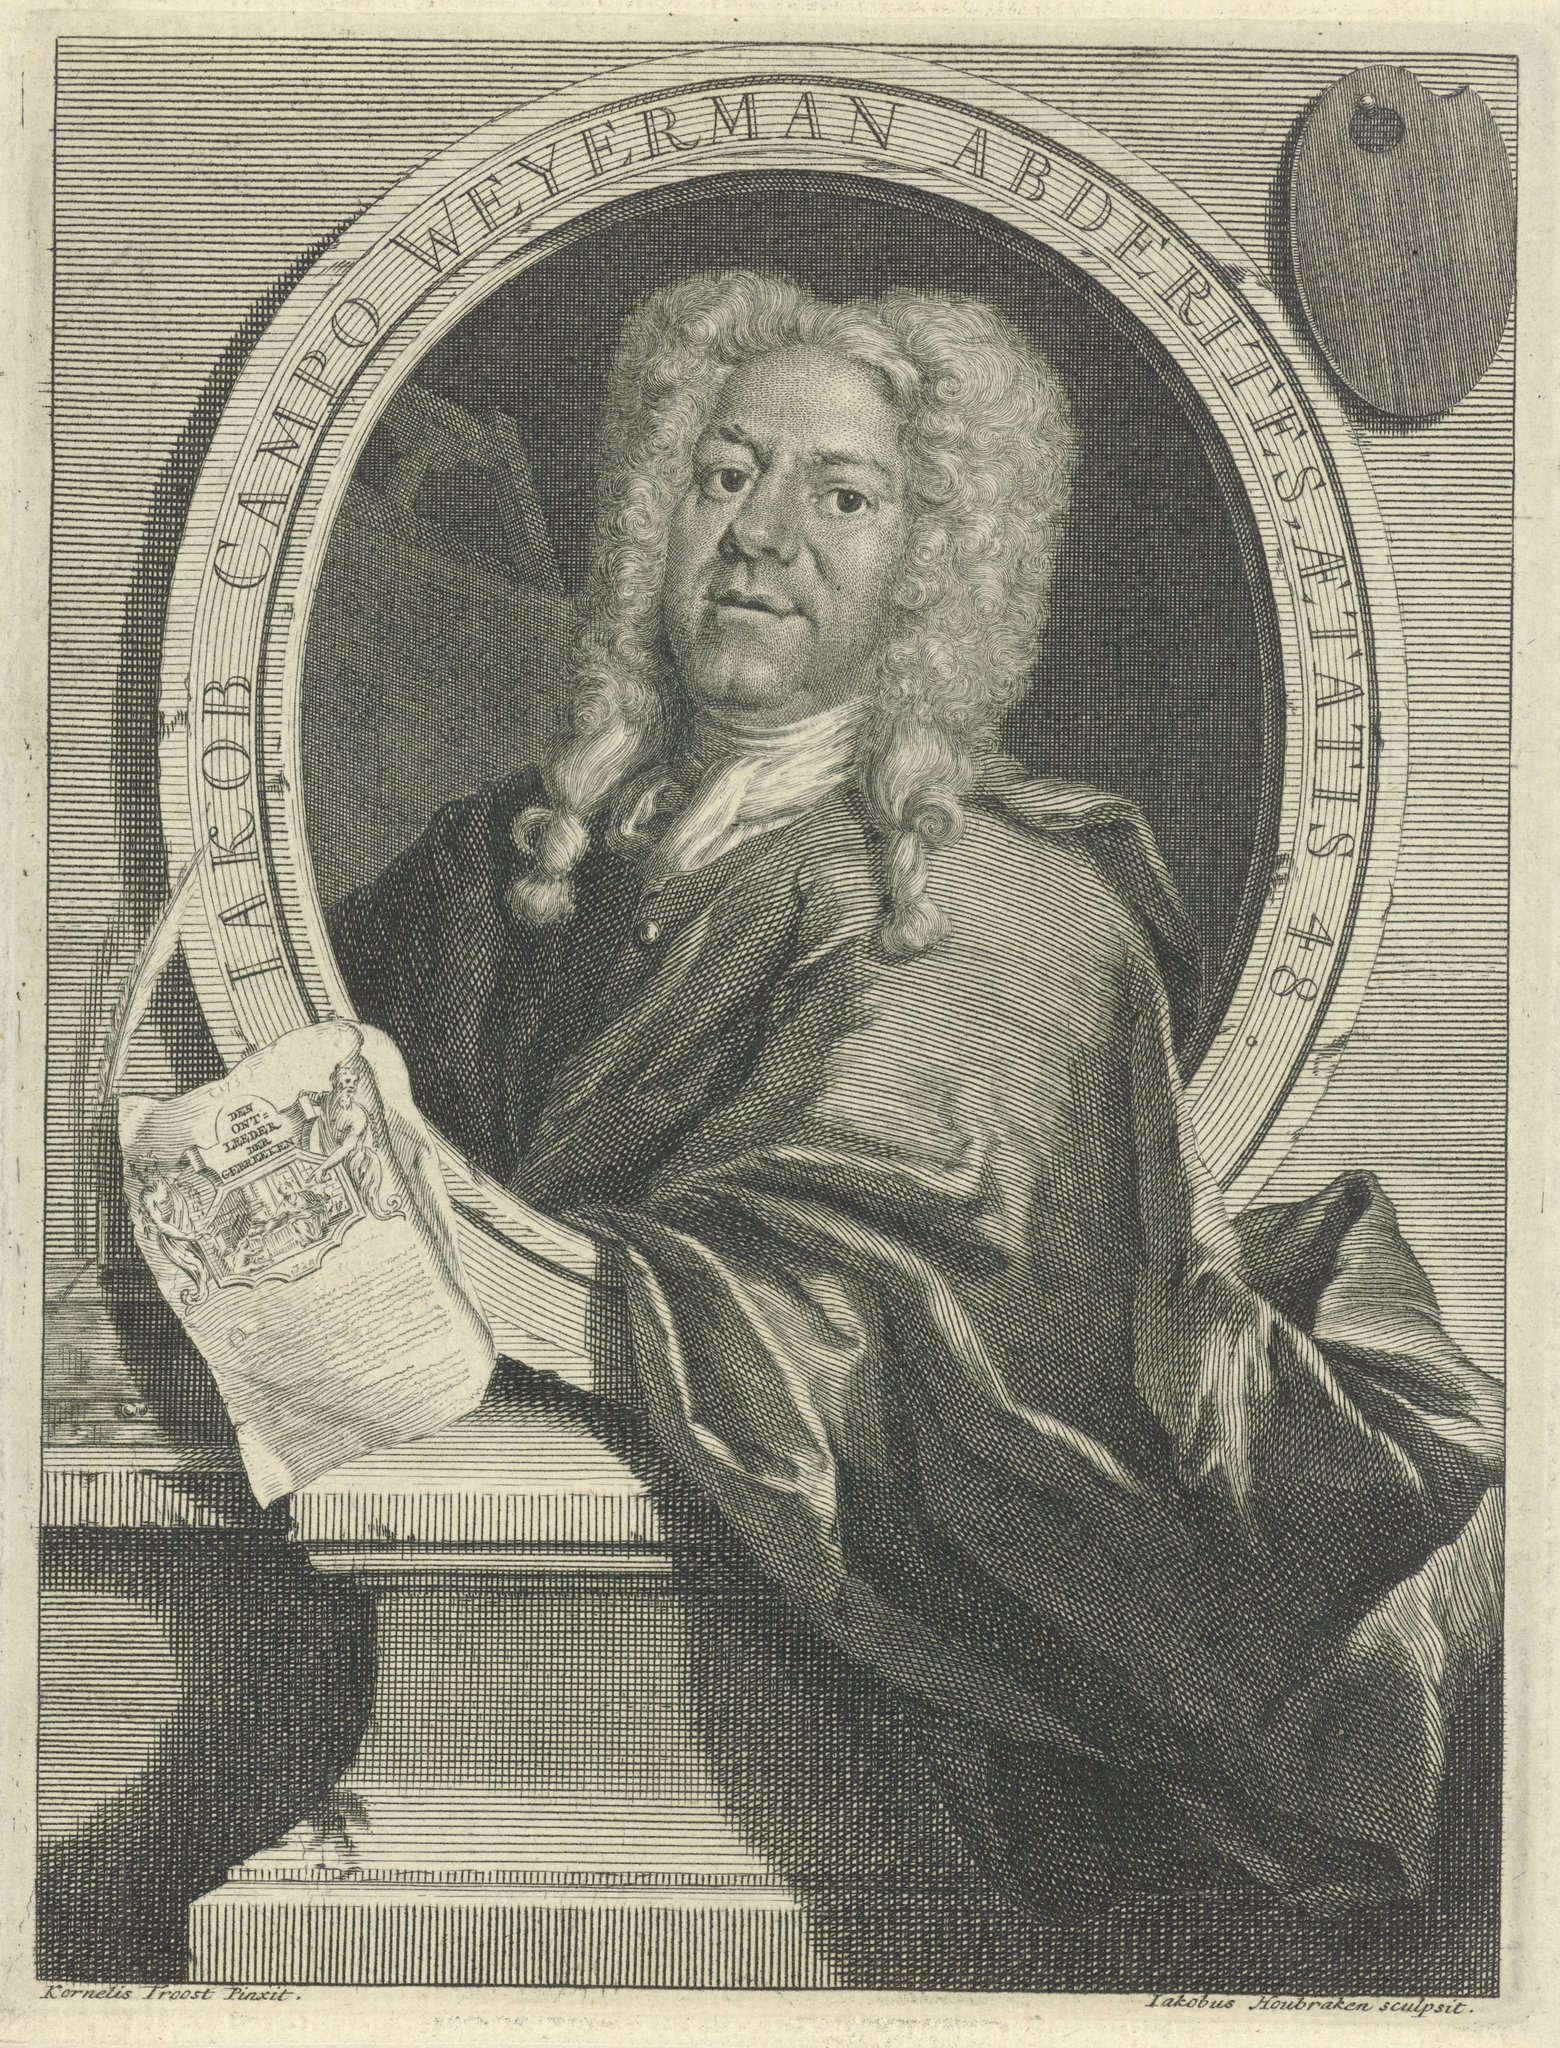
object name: print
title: Iakob Campo Weyerman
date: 1724-1747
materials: paper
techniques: engraving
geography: amsterdam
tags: the hague, painter, print maker, jacob campo weyerman, palette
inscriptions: collector's mark: Lugt 2228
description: Buste naar links van Jacob Campo Weyerman op 48-jarige leeftijd in een ovale architectonische omlijsting met randschrift in het Latijn, waarbij zijn linkermouw over de rand steekt. Het portret rust op een piëdestal. Rechtsboven een schilderspalet aan een haakje en linksonder een vel papier, waarop de tekst: Den ontleeder der gebreeken.